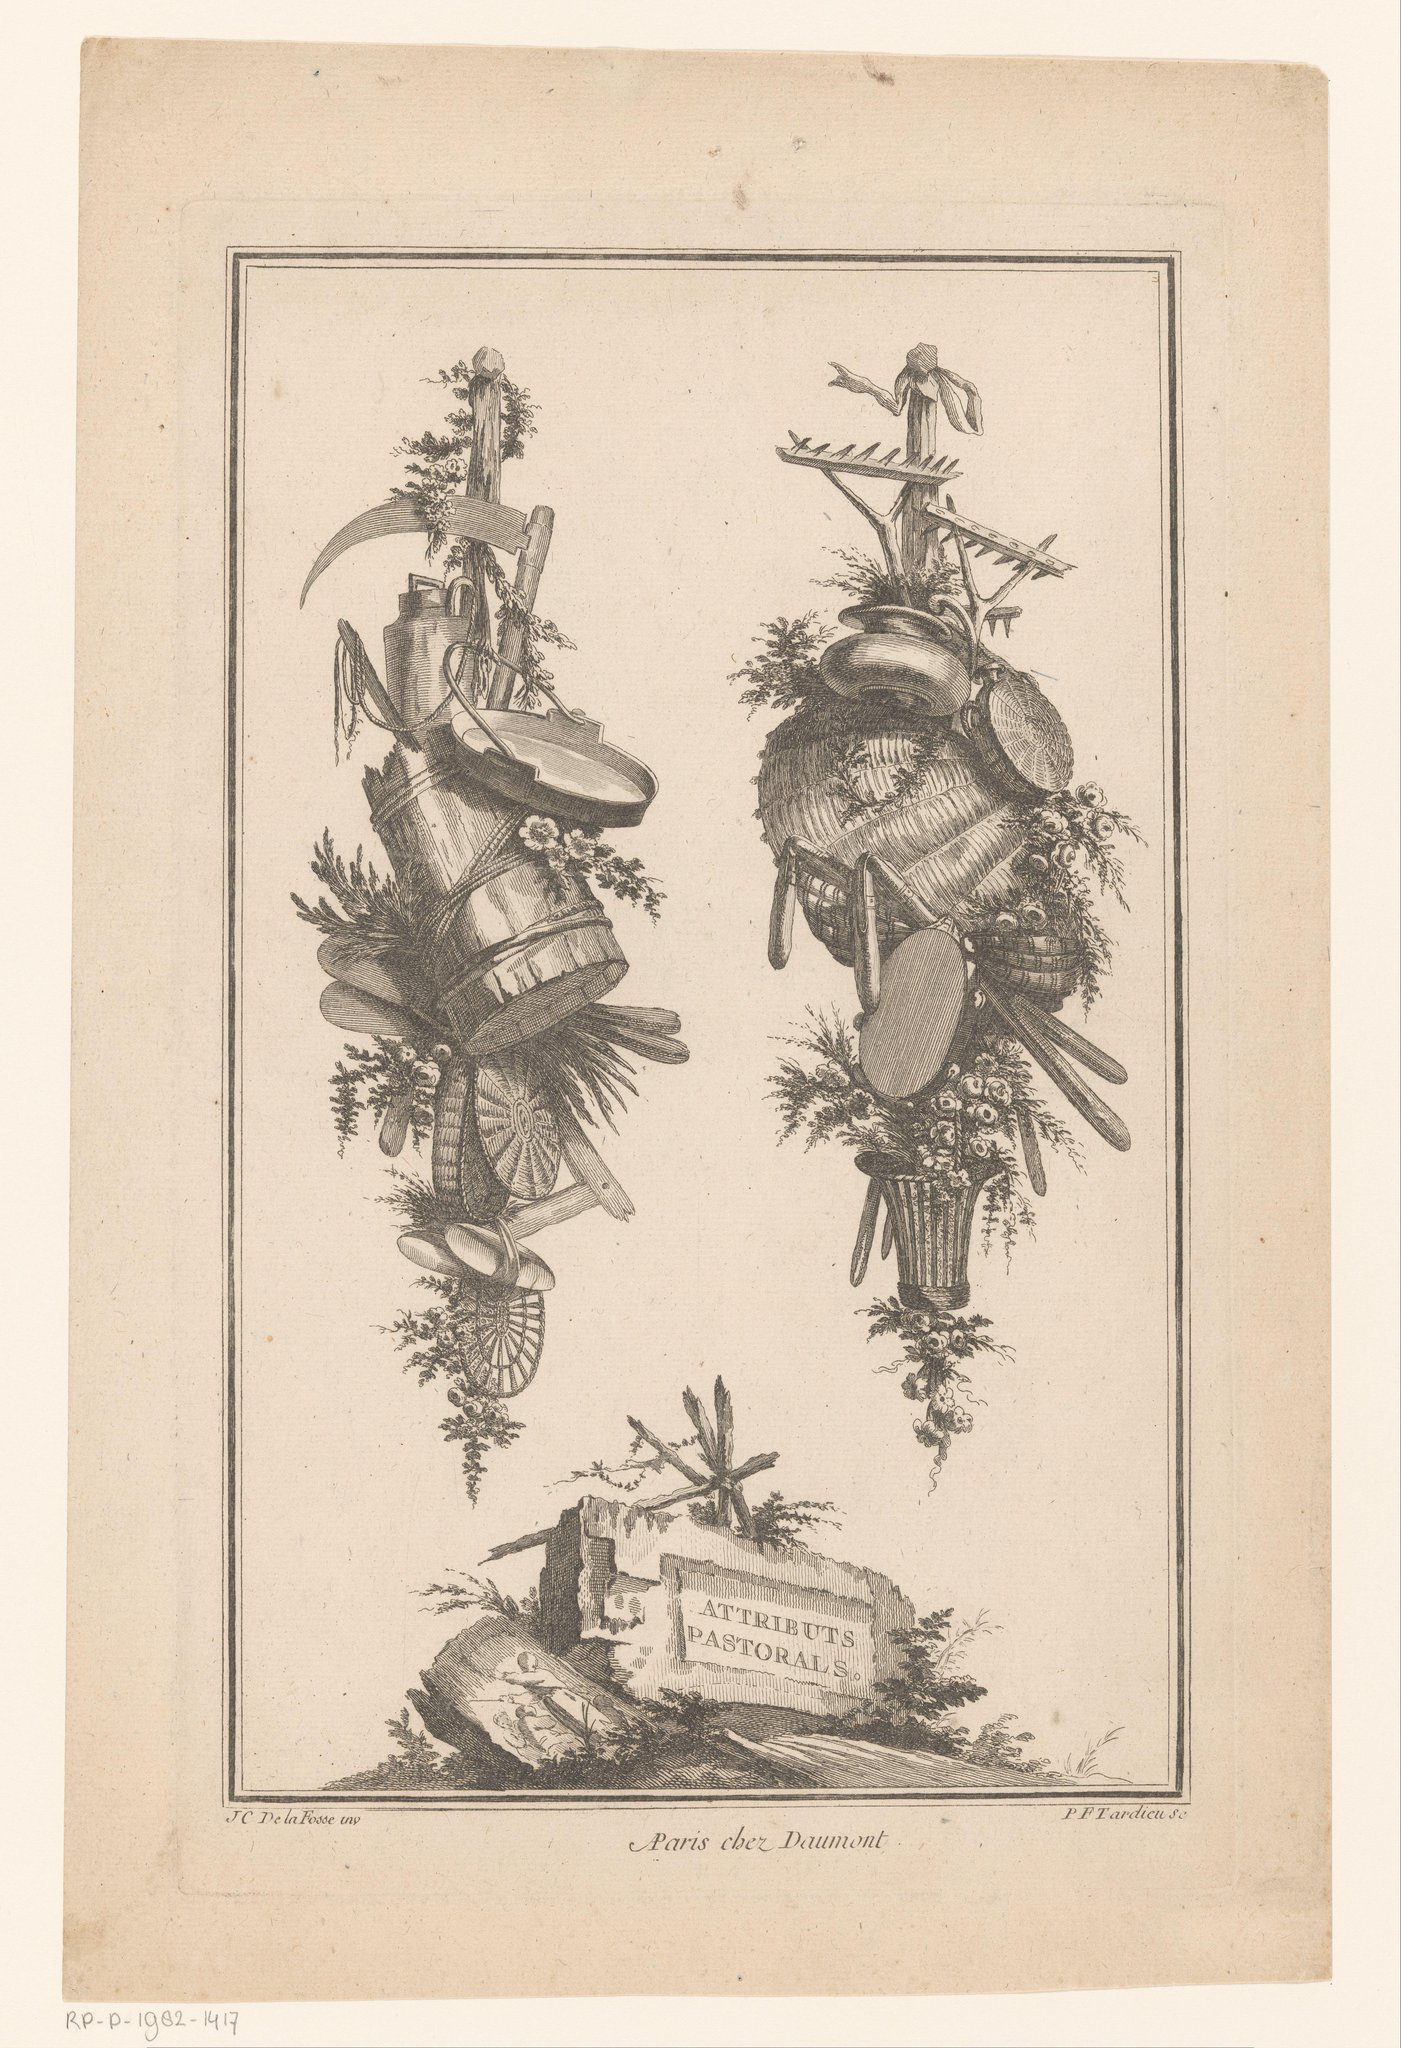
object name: print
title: Attributs pastorals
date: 1744-1771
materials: paper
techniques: etching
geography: paris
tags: trophy, i.e.: decorative arrangement of symbolic or typical objects ~ ornament, agricultural implements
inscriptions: collector's mark: Lugt 2760, collector's mark: Lugt 2228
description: Twee trofeeën met agrarische attributen zoals een zeis, een melkkan, een wan, een karnton, manden, harken, dorsvlegels en manden met bloemen.